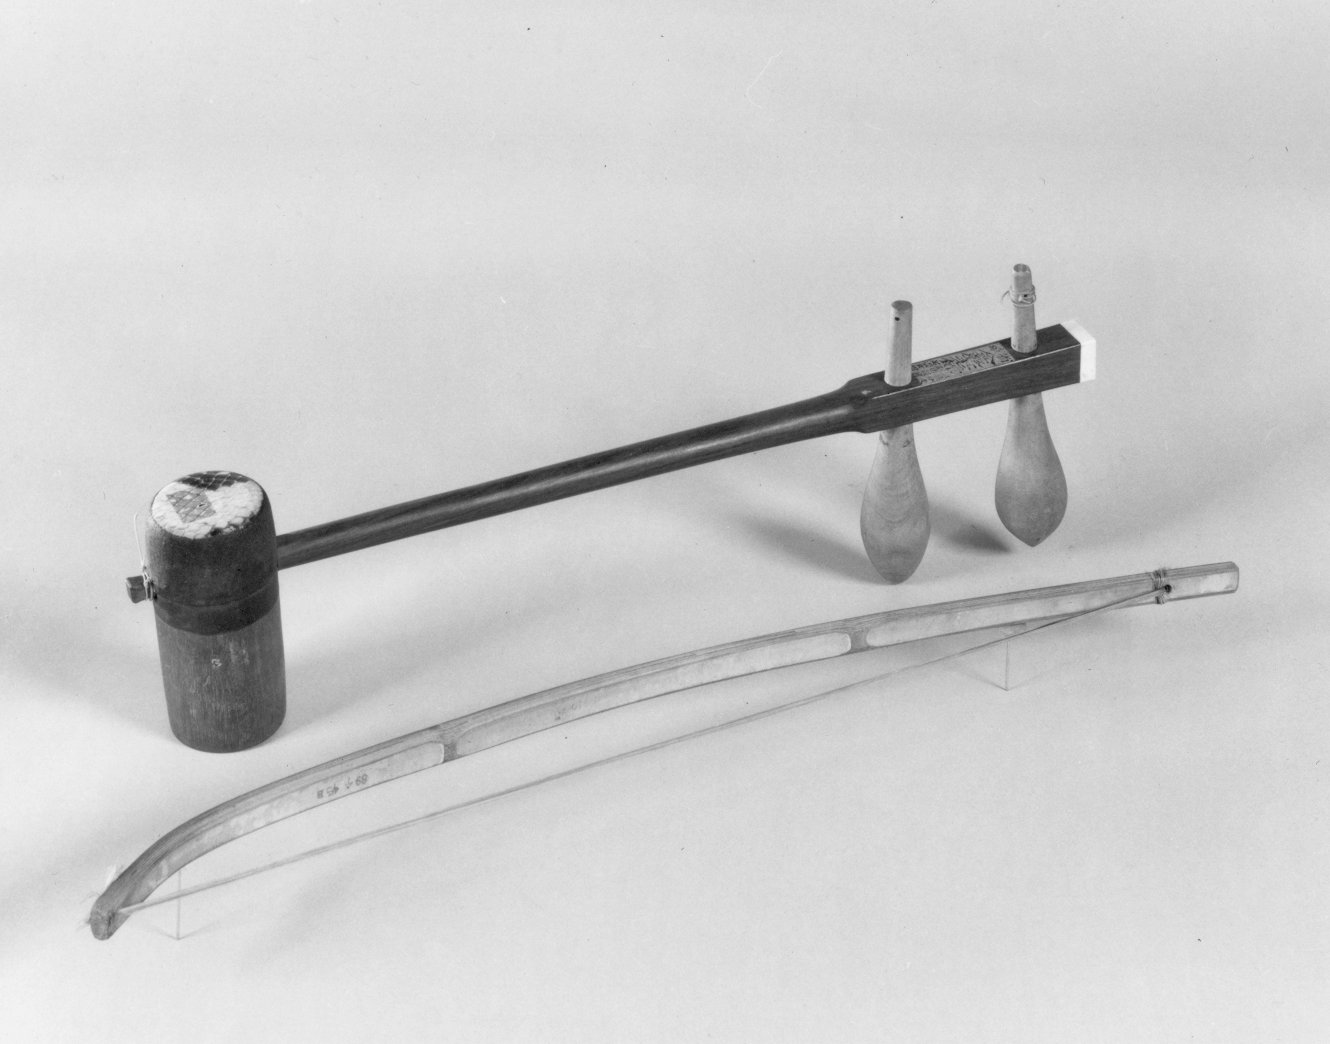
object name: hu chin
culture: chinese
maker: golden tone workshop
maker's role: maker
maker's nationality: chinese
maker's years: 1800-1900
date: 1801-1900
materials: skin, wood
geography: china